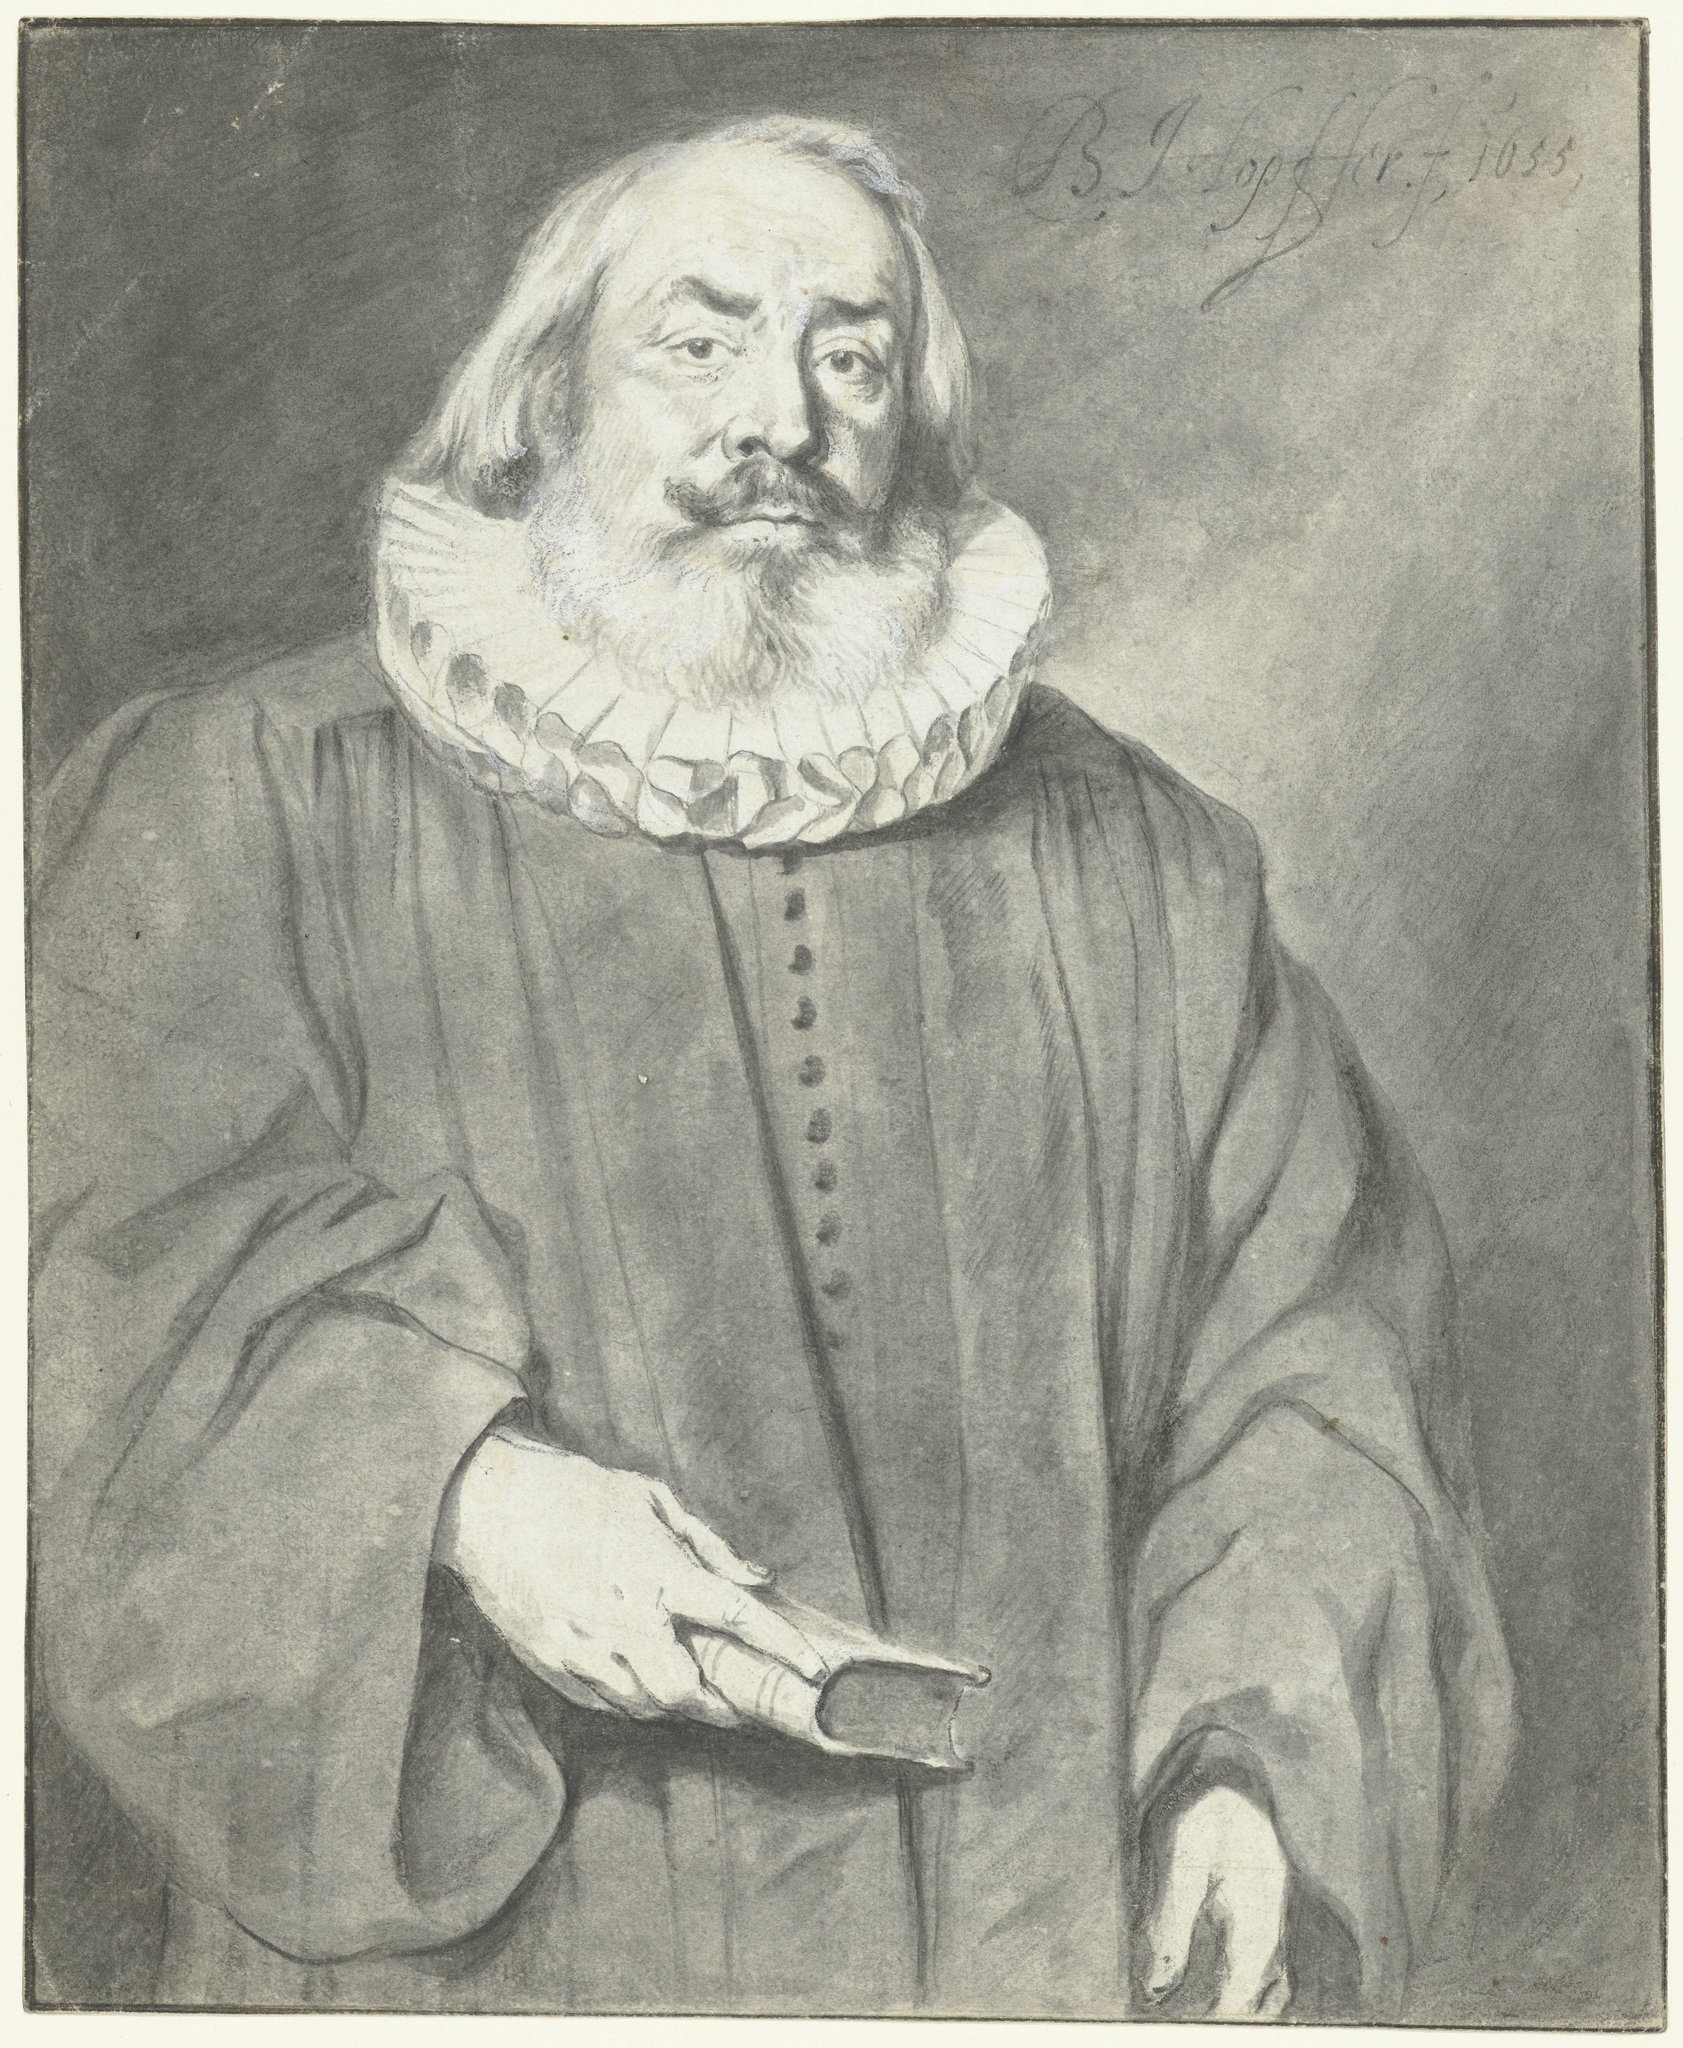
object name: drawing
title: Portret van Leonhard Fussenegger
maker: bartholomäus hopfer (ii)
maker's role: draughtsman, painter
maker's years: 1628-1699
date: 1655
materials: chalk, ink, paper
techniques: brush, pen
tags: augsburg, functionaries and dignitaries (with name) ~ episcopal protestant churches, theologian, historical persons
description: Portret van Leonhard Fussenegger, lutheraan, theoloog en predikant (1594 Augsburg - 1671). Ontwerp voor een prent.